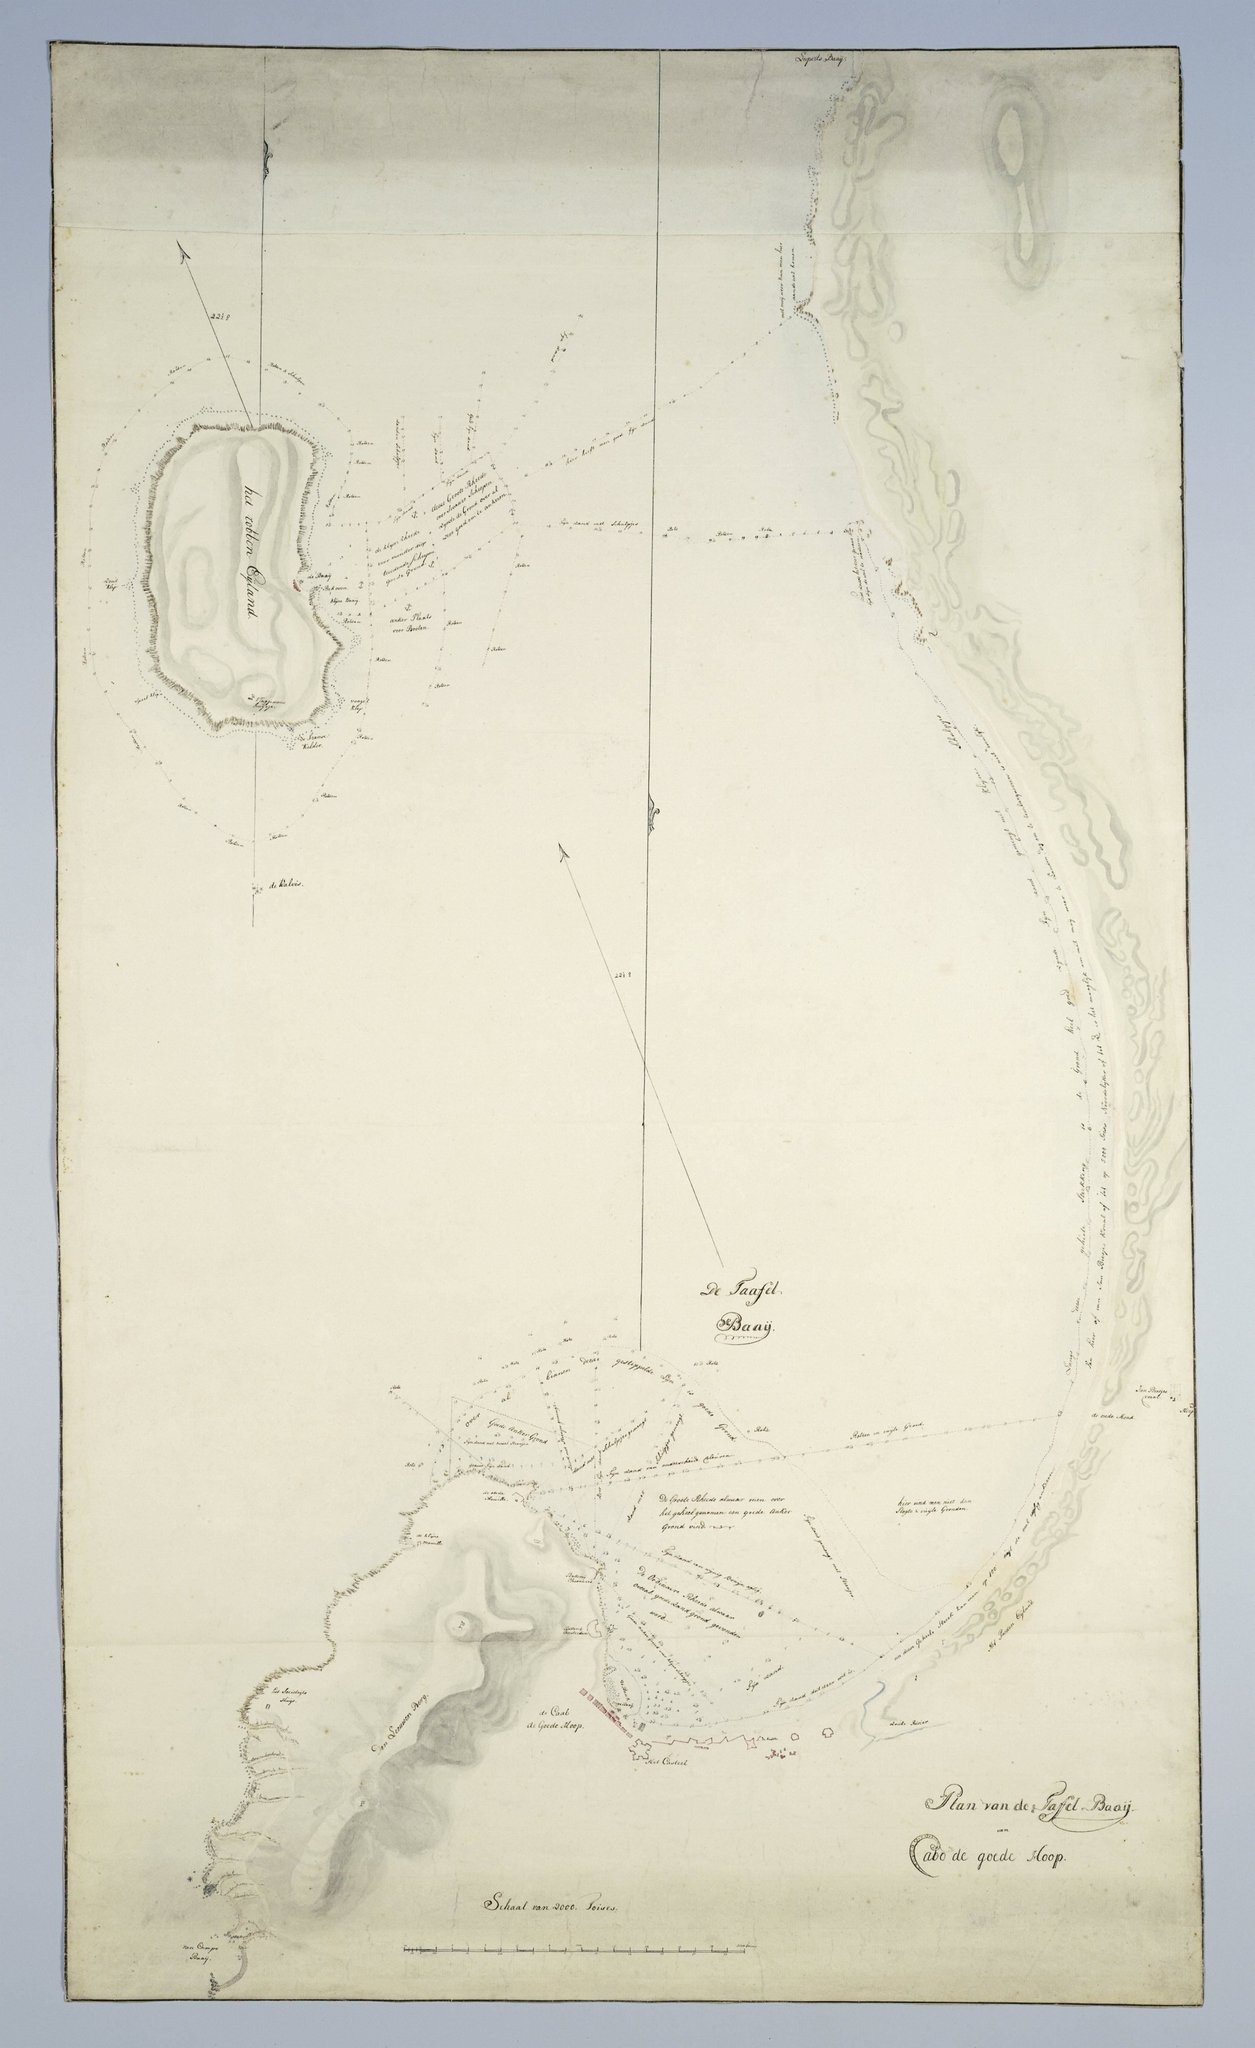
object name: topographical view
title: Map of Table Bay and Robben Island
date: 1788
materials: ink, paper, pencil, watercolor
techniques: brush, pen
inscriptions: annotation: ‘delen A t/m G, zie ook De Jong’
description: Ontsloten door middel van een gidskaart met afgebakende gebieden, aangeduid door de letters A t/m G met aanduidingen van het soort zand, de aanwezige rotsen en locaties met hun namen; deel F: Kaapstad, geeft ook de namen van de gebouwen langs de Tafelbaai aan.